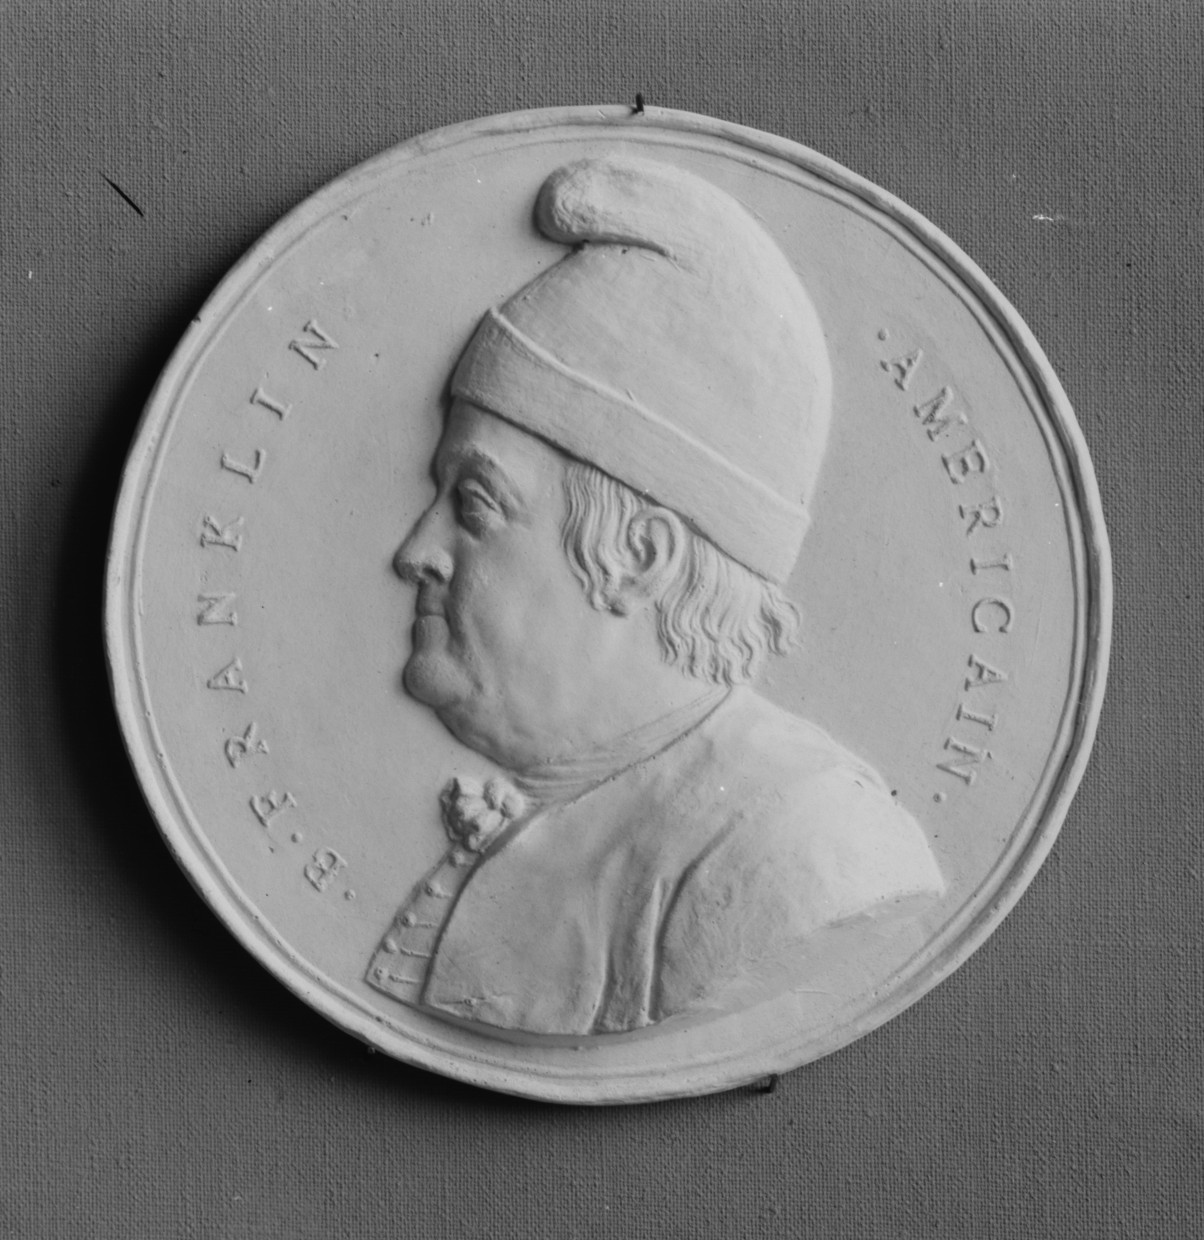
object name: medallion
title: Benjamin Franklin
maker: jean-baptiste nini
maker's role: artist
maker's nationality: italian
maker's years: 1717-1786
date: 1701-1800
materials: plaster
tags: benjamin franklin,profiles